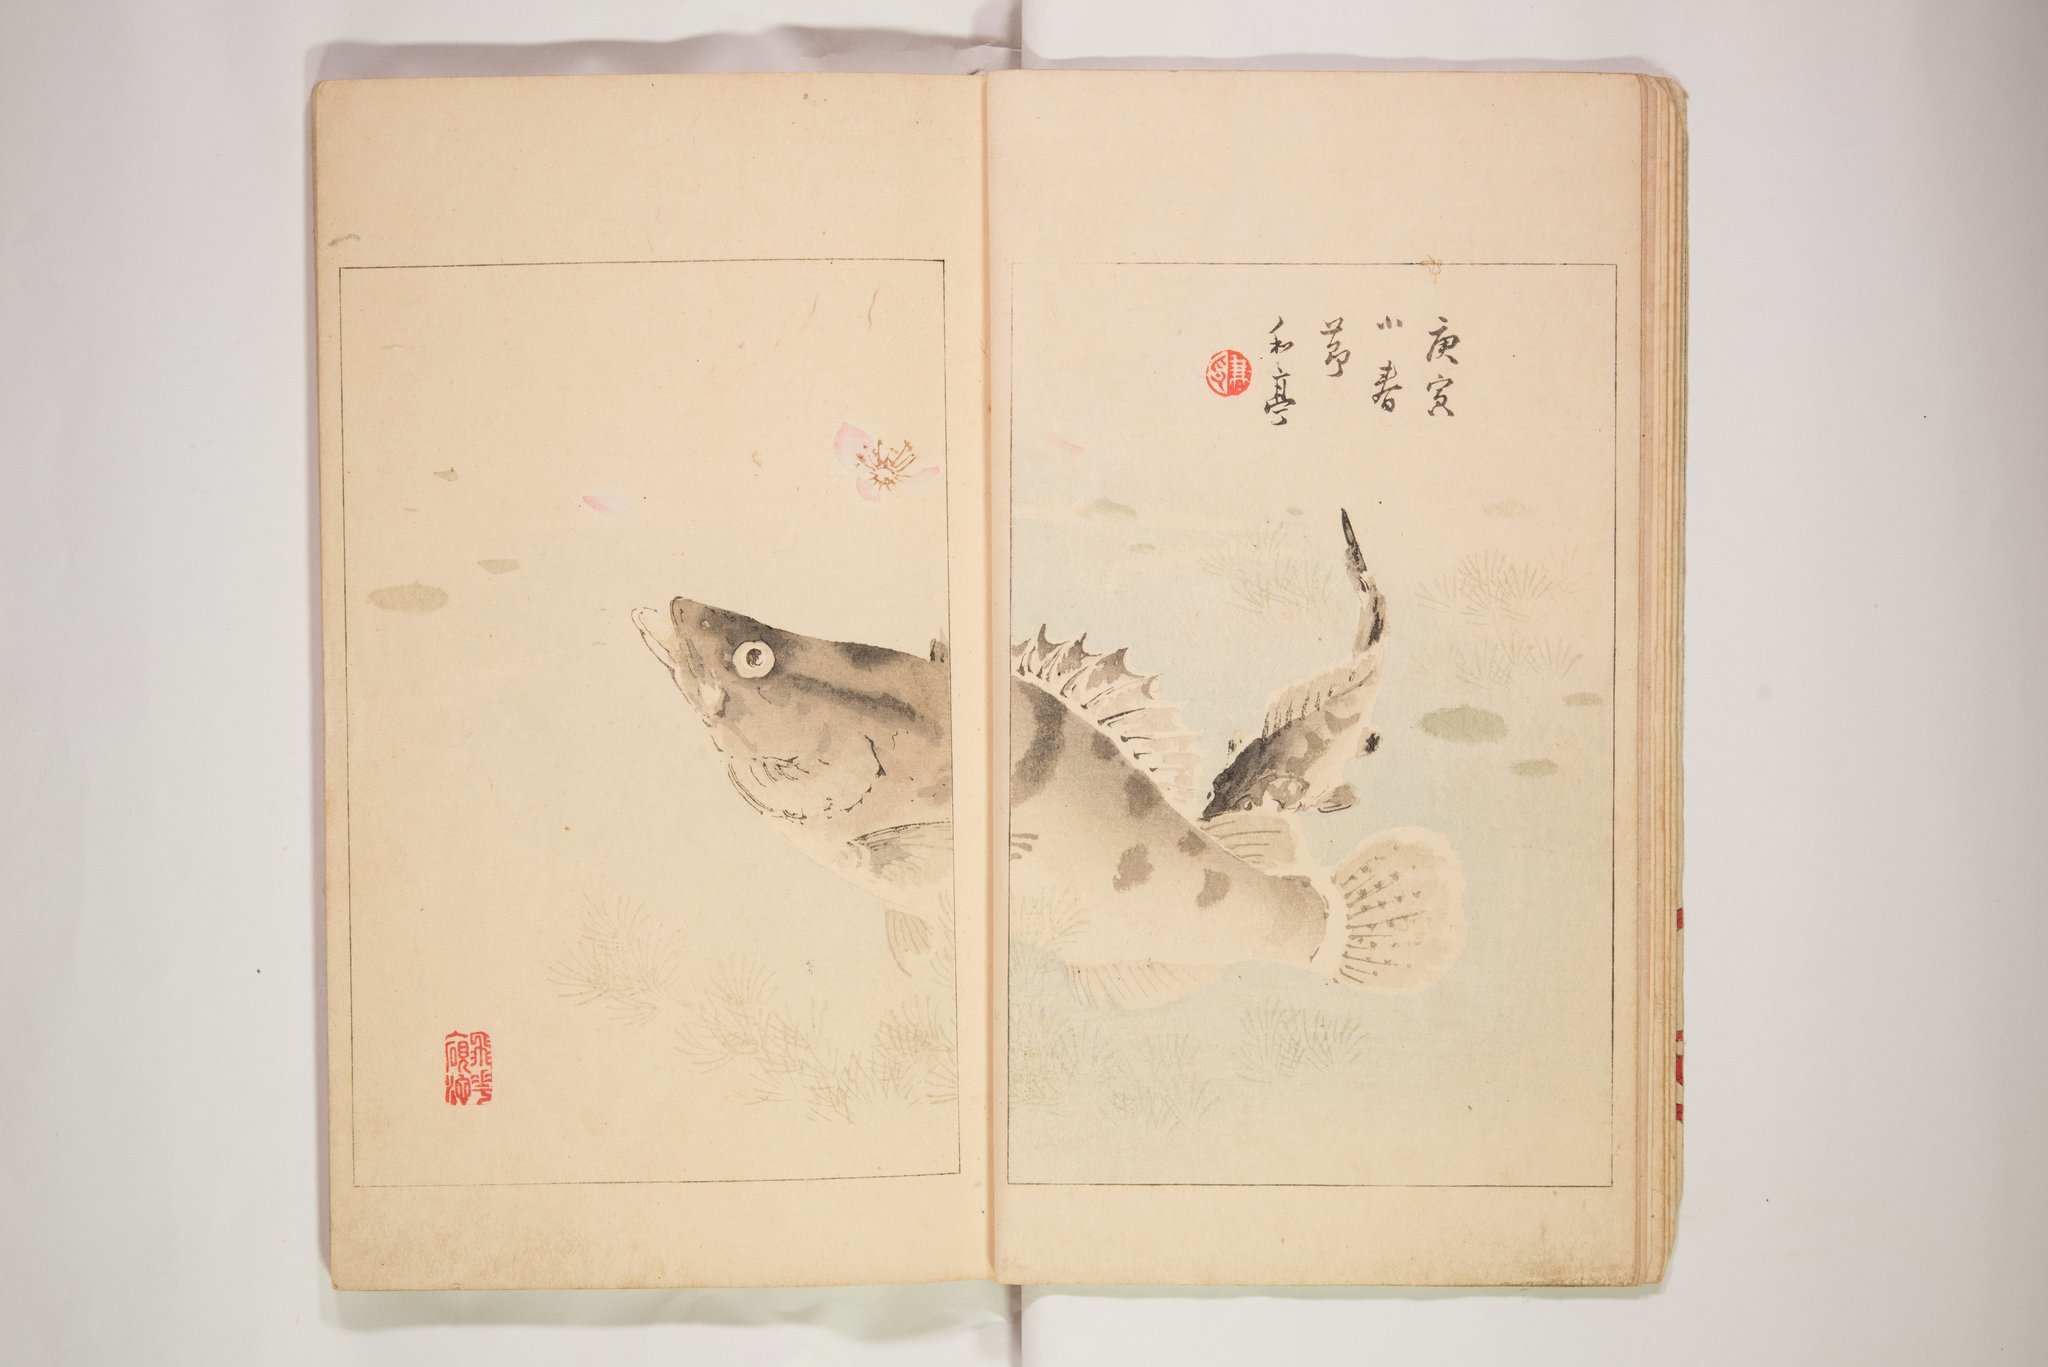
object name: illustrated book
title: World of Fine Arts (Bijutsu Sekai) 美術世界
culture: japanese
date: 1890-1893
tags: fish